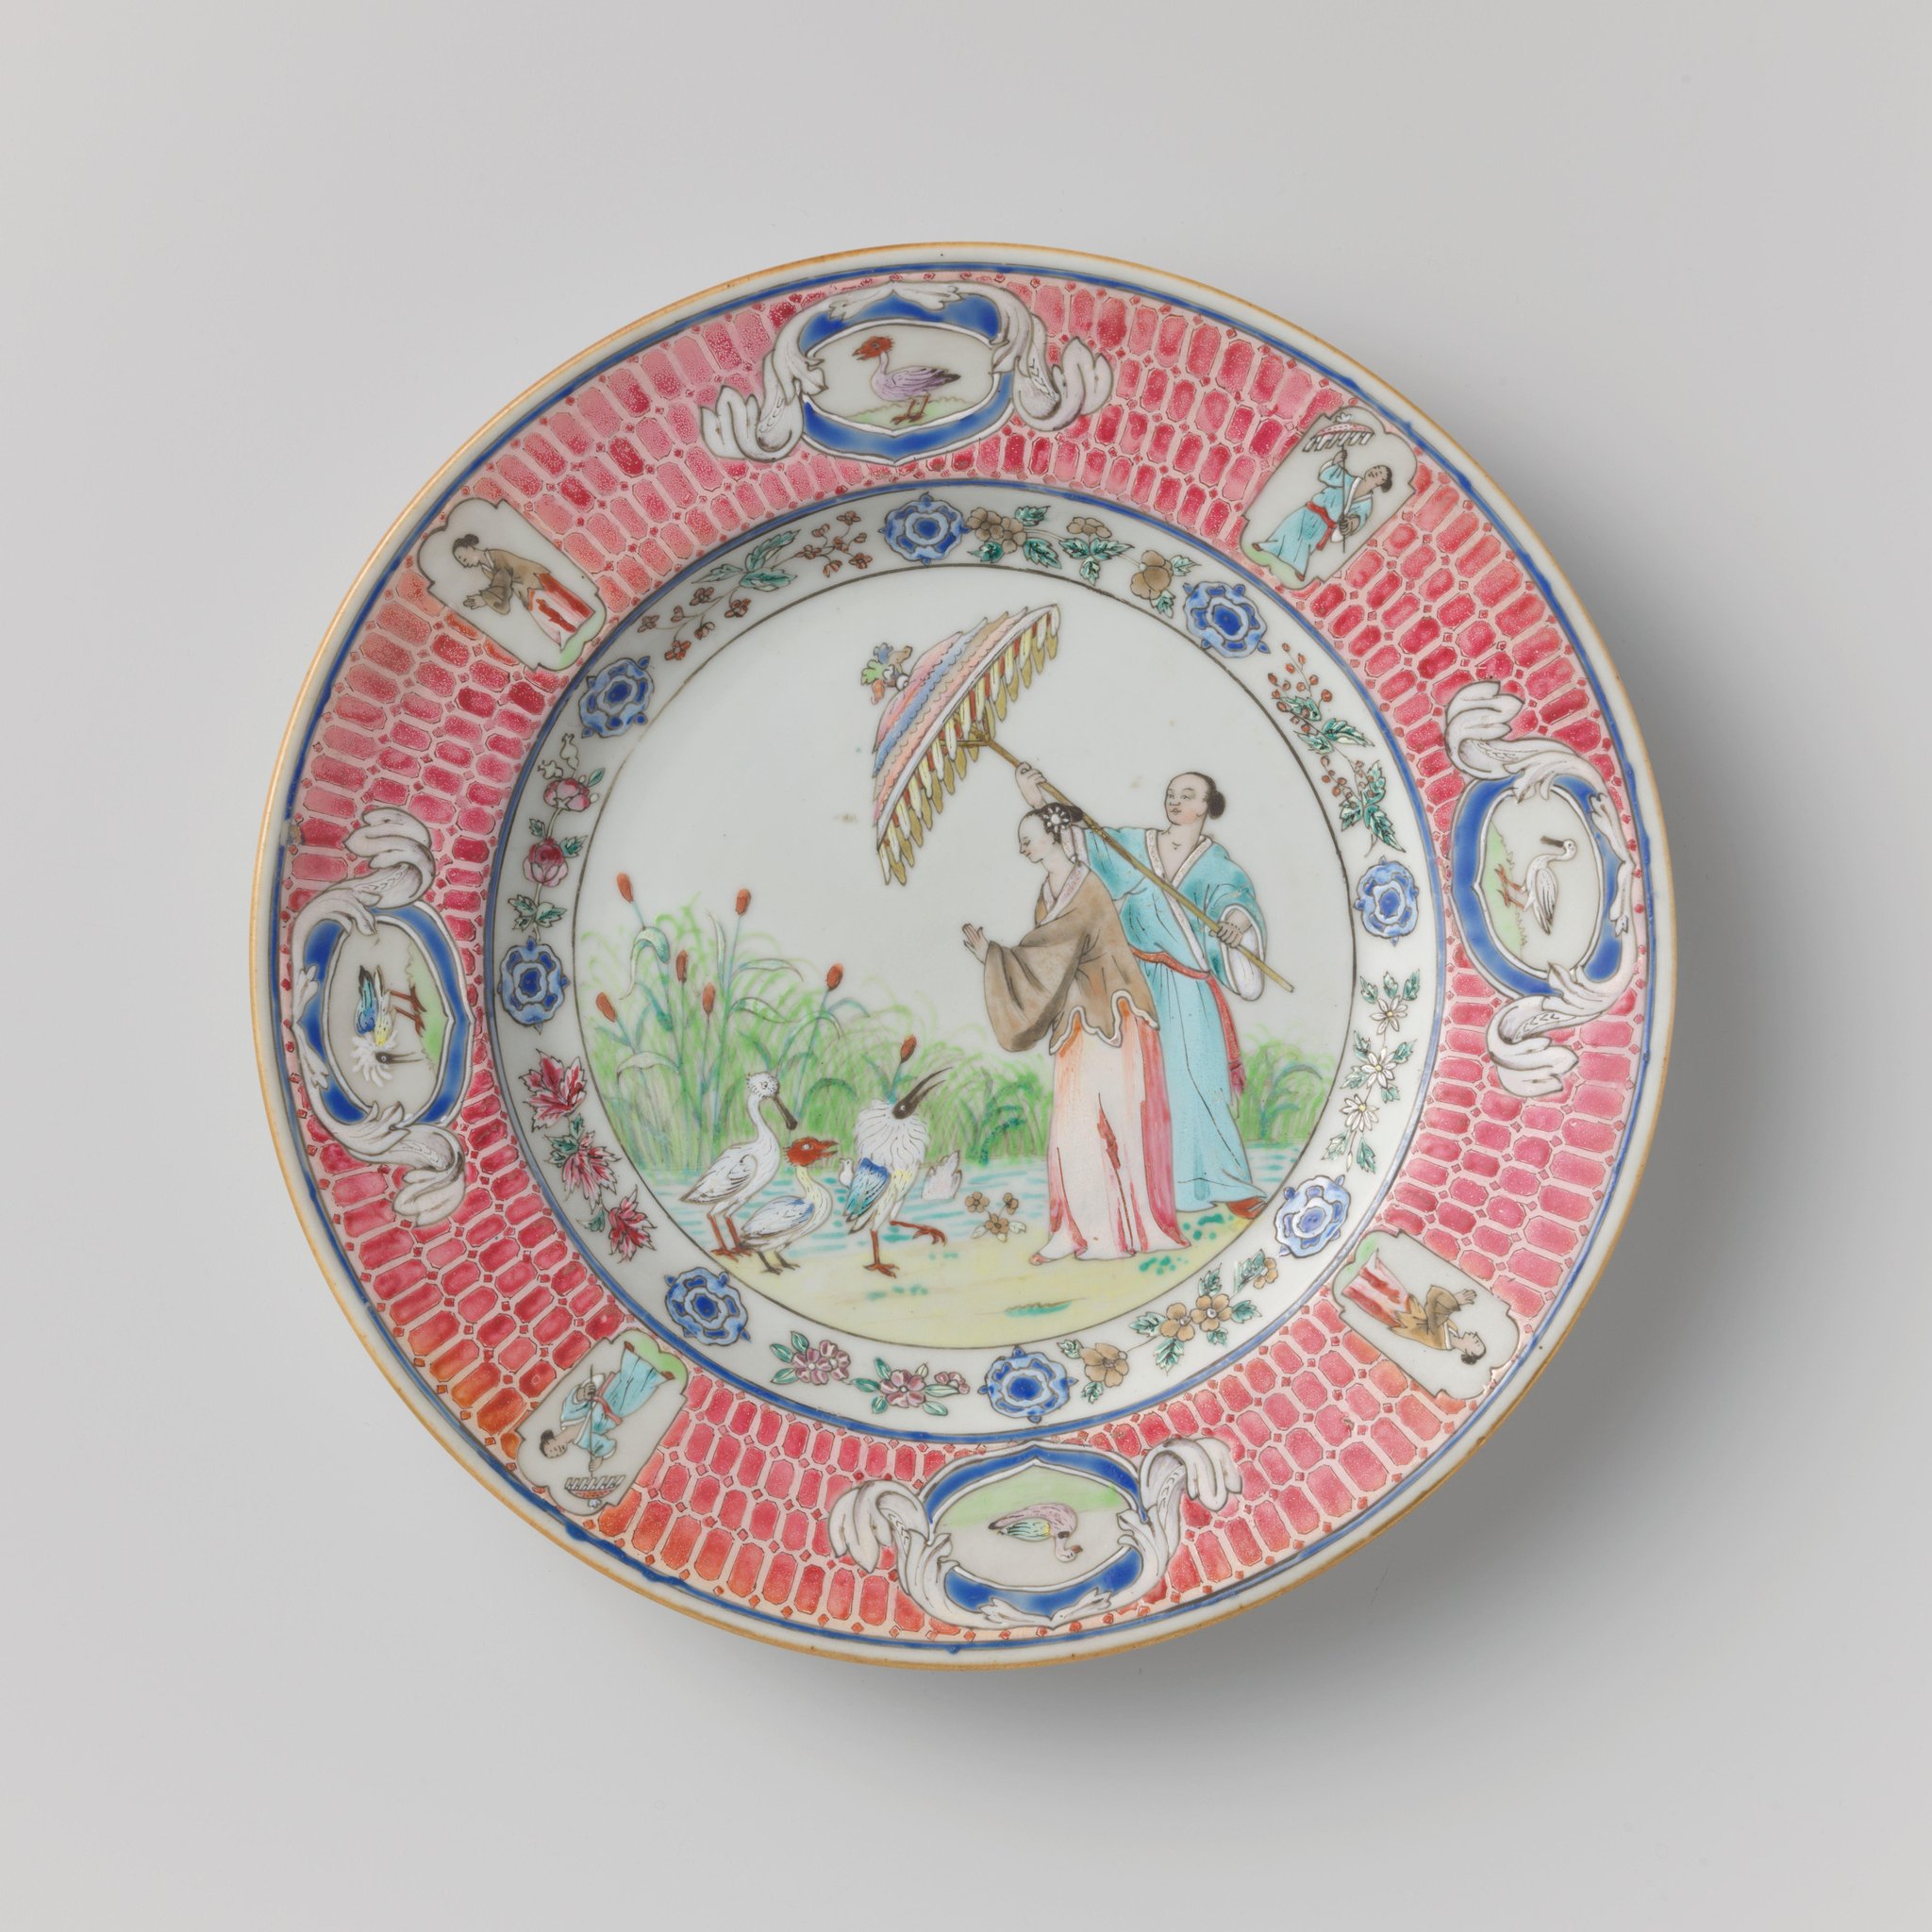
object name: plate dish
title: Plate with an image of The Parasol Lady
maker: Anonymous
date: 1736-1738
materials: glaze, gold, paint, porcelain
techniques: firing, gilding, turning, vitrification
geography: netherlands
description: In 1734 werd door de directeuren van de VOC opdracht gegeven aan de Amsterdamse kunstenaar Cornelis Pronk (1691-1754) een serie ontwerpen te maken voor de decoratie van Chinees porselein. In totaal maakte Pronk vier verschillende tekeningen. Twee ontwerpen die Pronk maakte kunnen met zekerheid aan hem worden toegeschreven, namelijk de Parasoldames en de Doctoren (zie bijvoorbeeld AK-NM-13703). Tekeningen met deze ontwerpen bevinden zich in het Prentenkabinet te Amsterdam. Het vierde ontwerp is het Prieel( zie bijvoorbeeld AK-NM-13528). Van dit ontwerp is geen tekening bewaard gebleven maar beschreven in de VOC archieven. Dus zijn de vele porseleinen voorwerpen met dit ontwerp te herleiden naar Pronk. Het ontwerp van de Boogschutter (zie bijvoorbeeld AK-RBK-1959-27) zou het derde ontwerp kunnen zijn omdat dit qua stijl overeenkomt met de andere ontwerpen. De tekeningen werden via Batavia naar Kanton gezonden in 1736. De ontwerpen van Pronk waren populair, en zijn zelfs in een latere periode terug te vinden op Japans porselein.